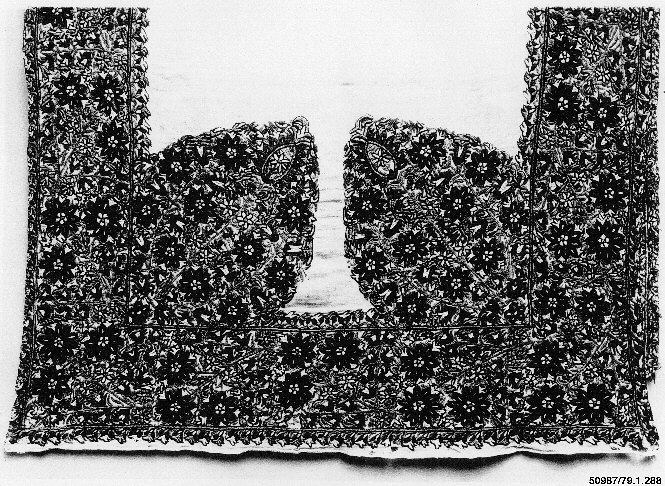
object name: textile fragment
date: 1601-1800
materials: linen, silk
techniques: embroidery, weave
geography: greece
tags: flowers